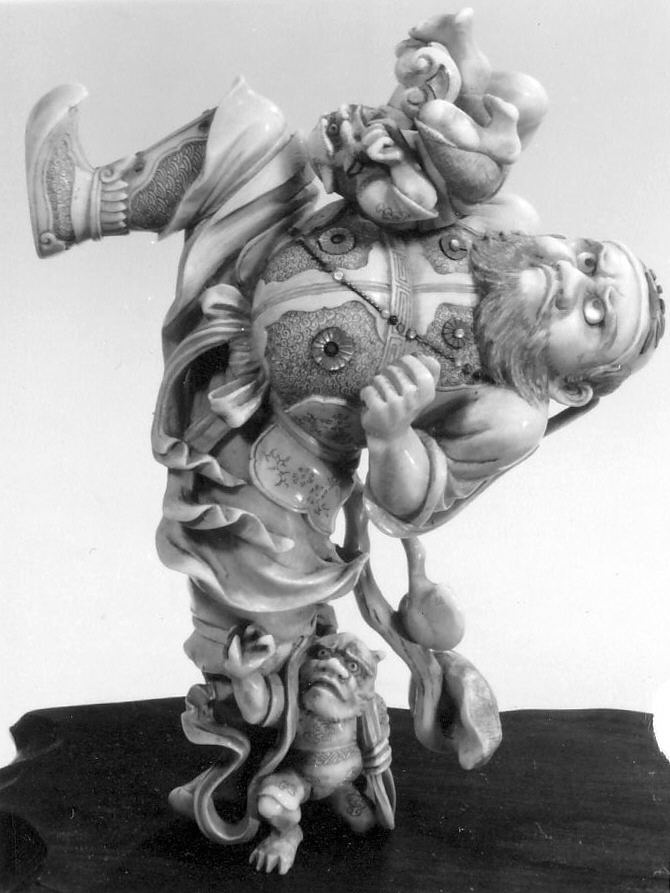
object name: figure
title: Standing Figure (Shoki) with Two Demons (Oni)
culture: japanese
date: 1867-1900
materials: ivory, mother of pearl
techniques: inlay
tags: demons